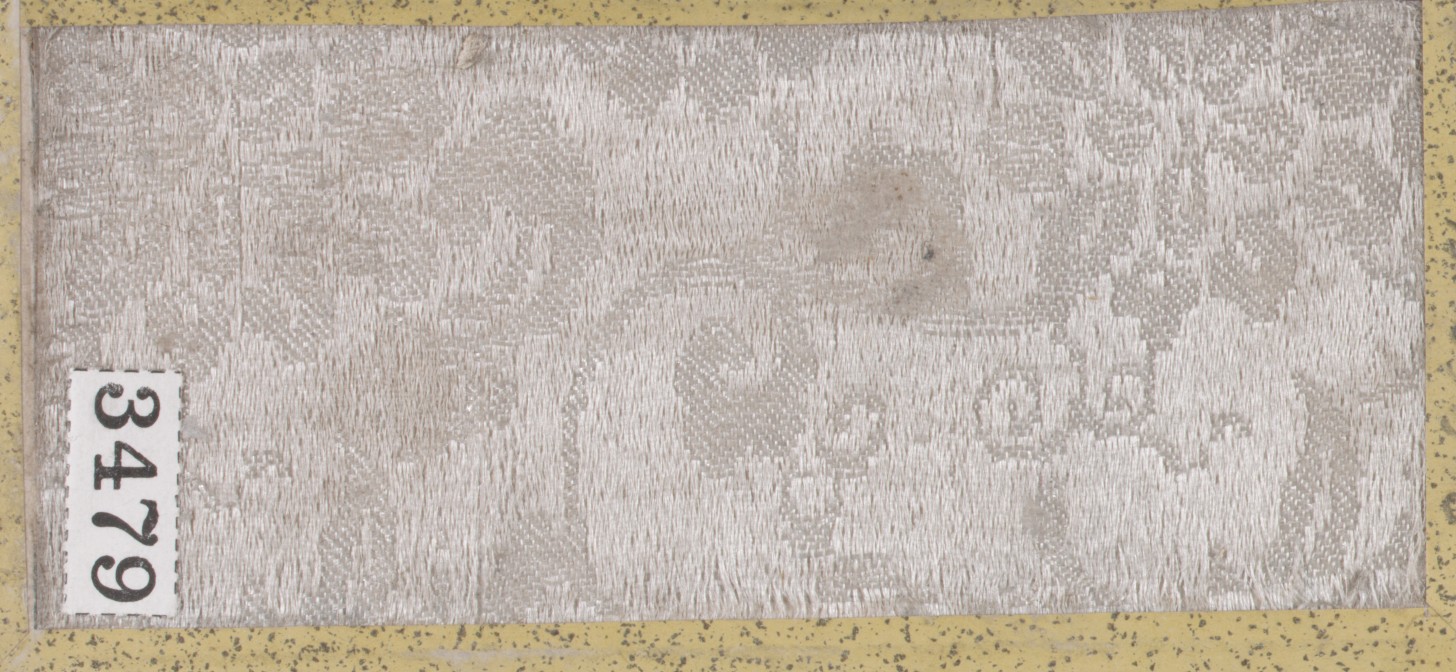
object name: sample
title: Textile Sample from Sample Book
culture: japanese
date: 1801-1900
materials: silk